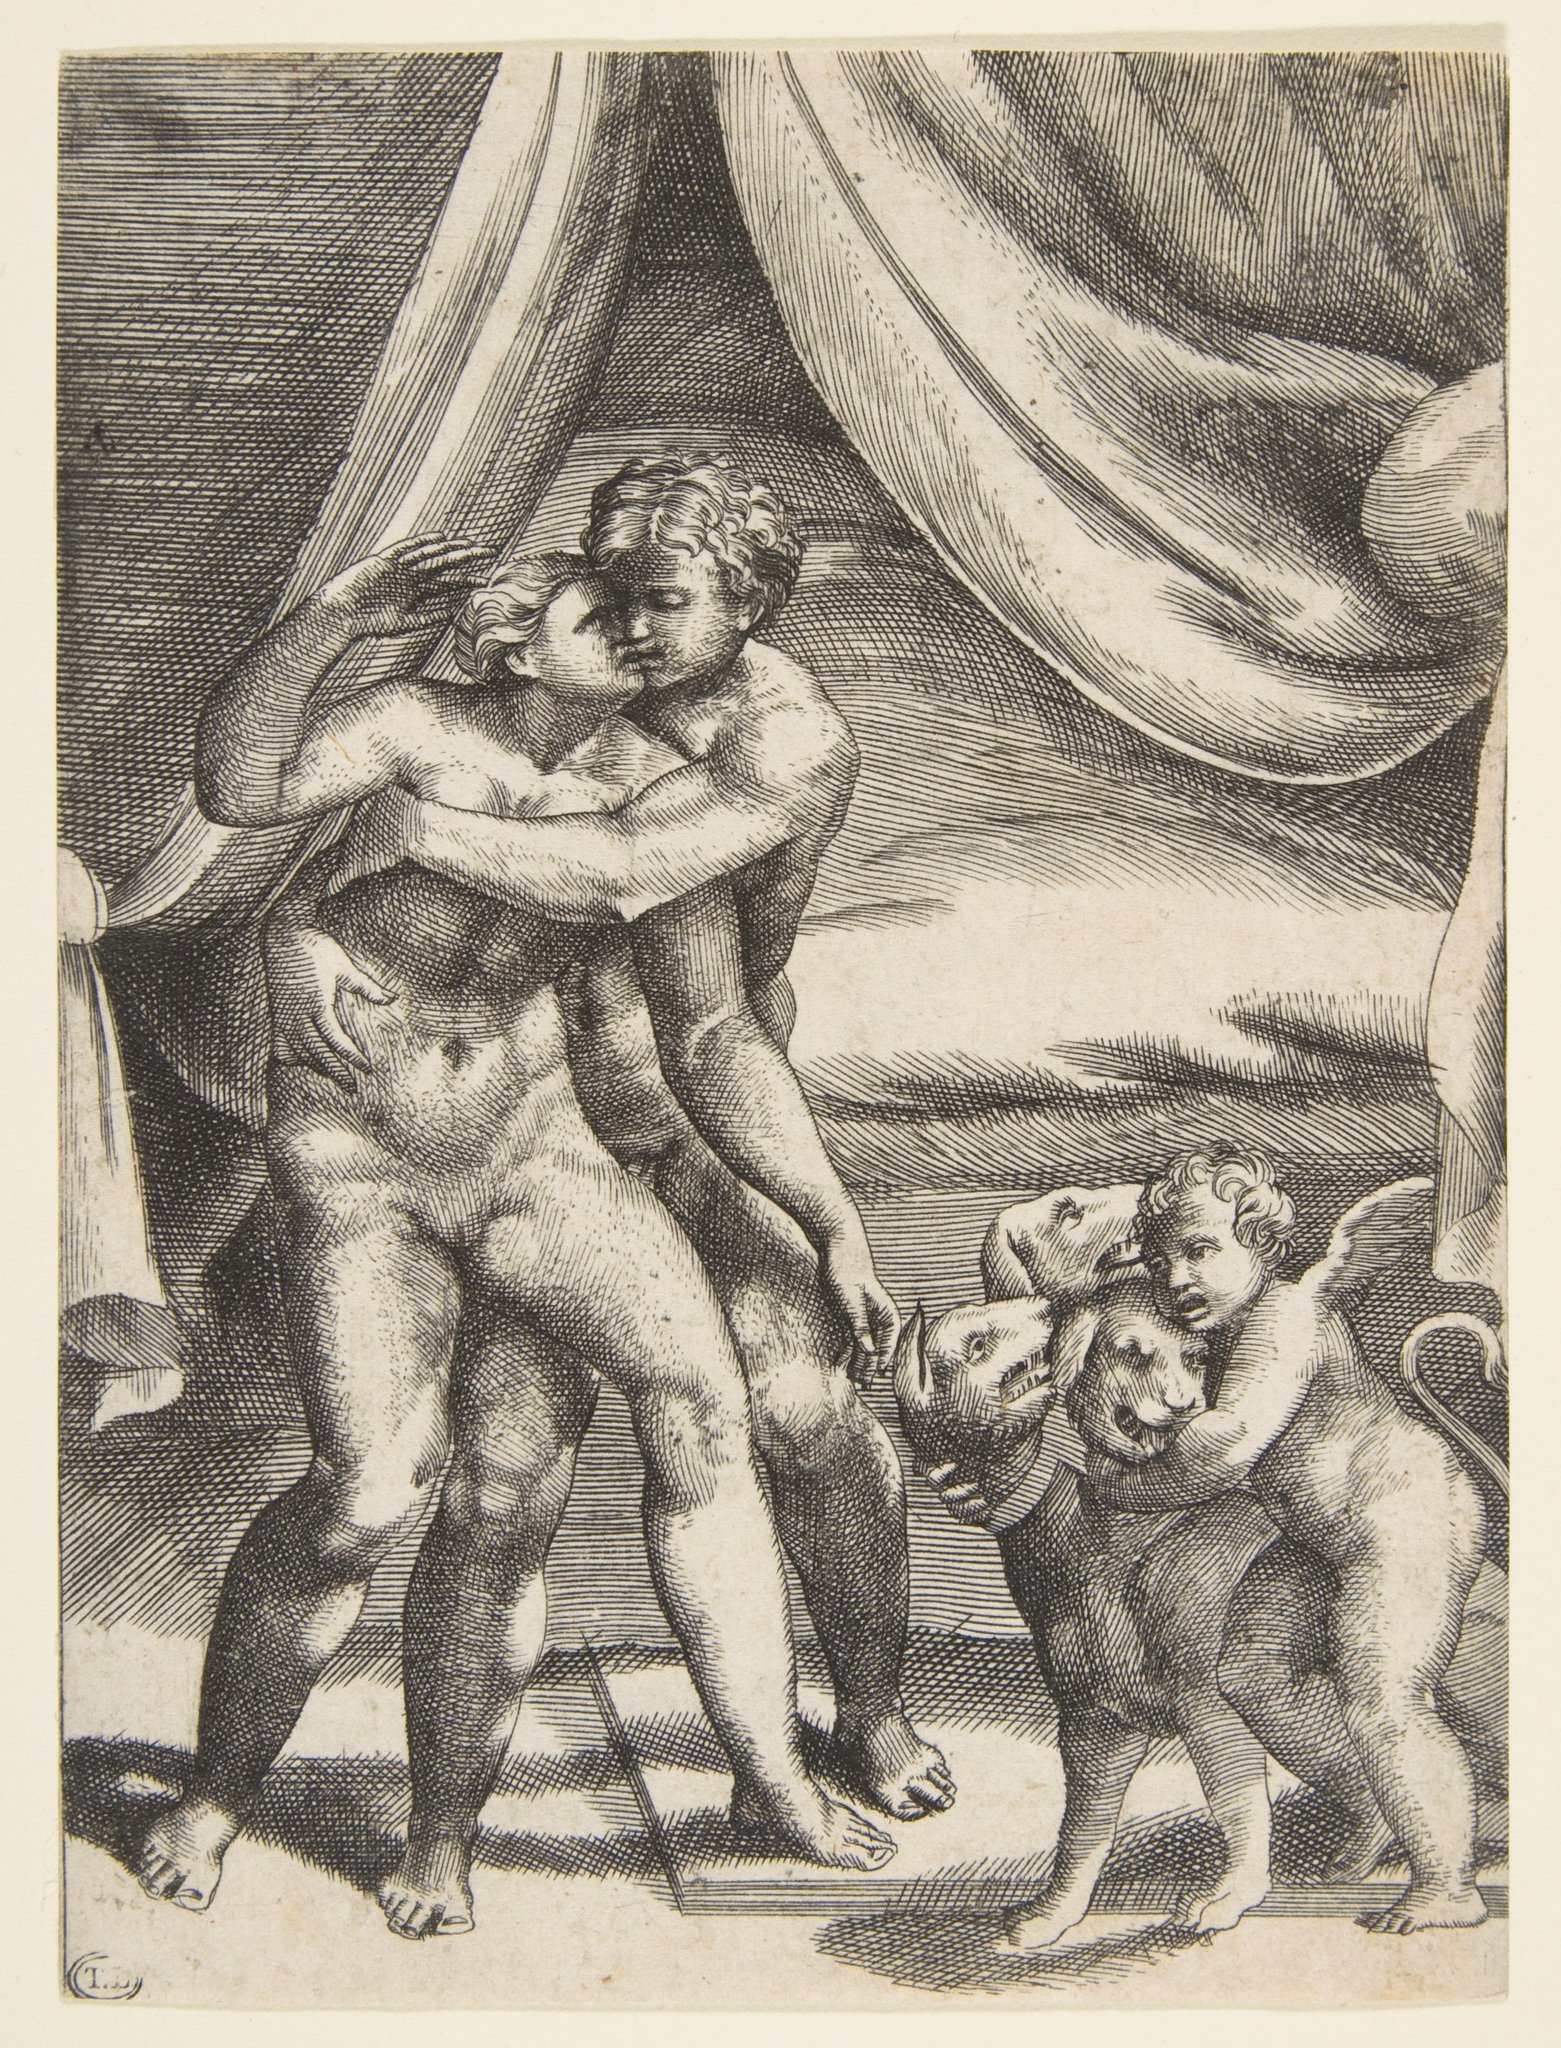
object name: print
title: Pluto and Proserpine, from "The Loves of the Gods"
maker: giulio bonasone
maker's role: artist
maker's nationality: italian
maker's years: 1510-1576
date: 1531-1576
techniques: engraving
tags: female nudes,putti,dogs,pluto